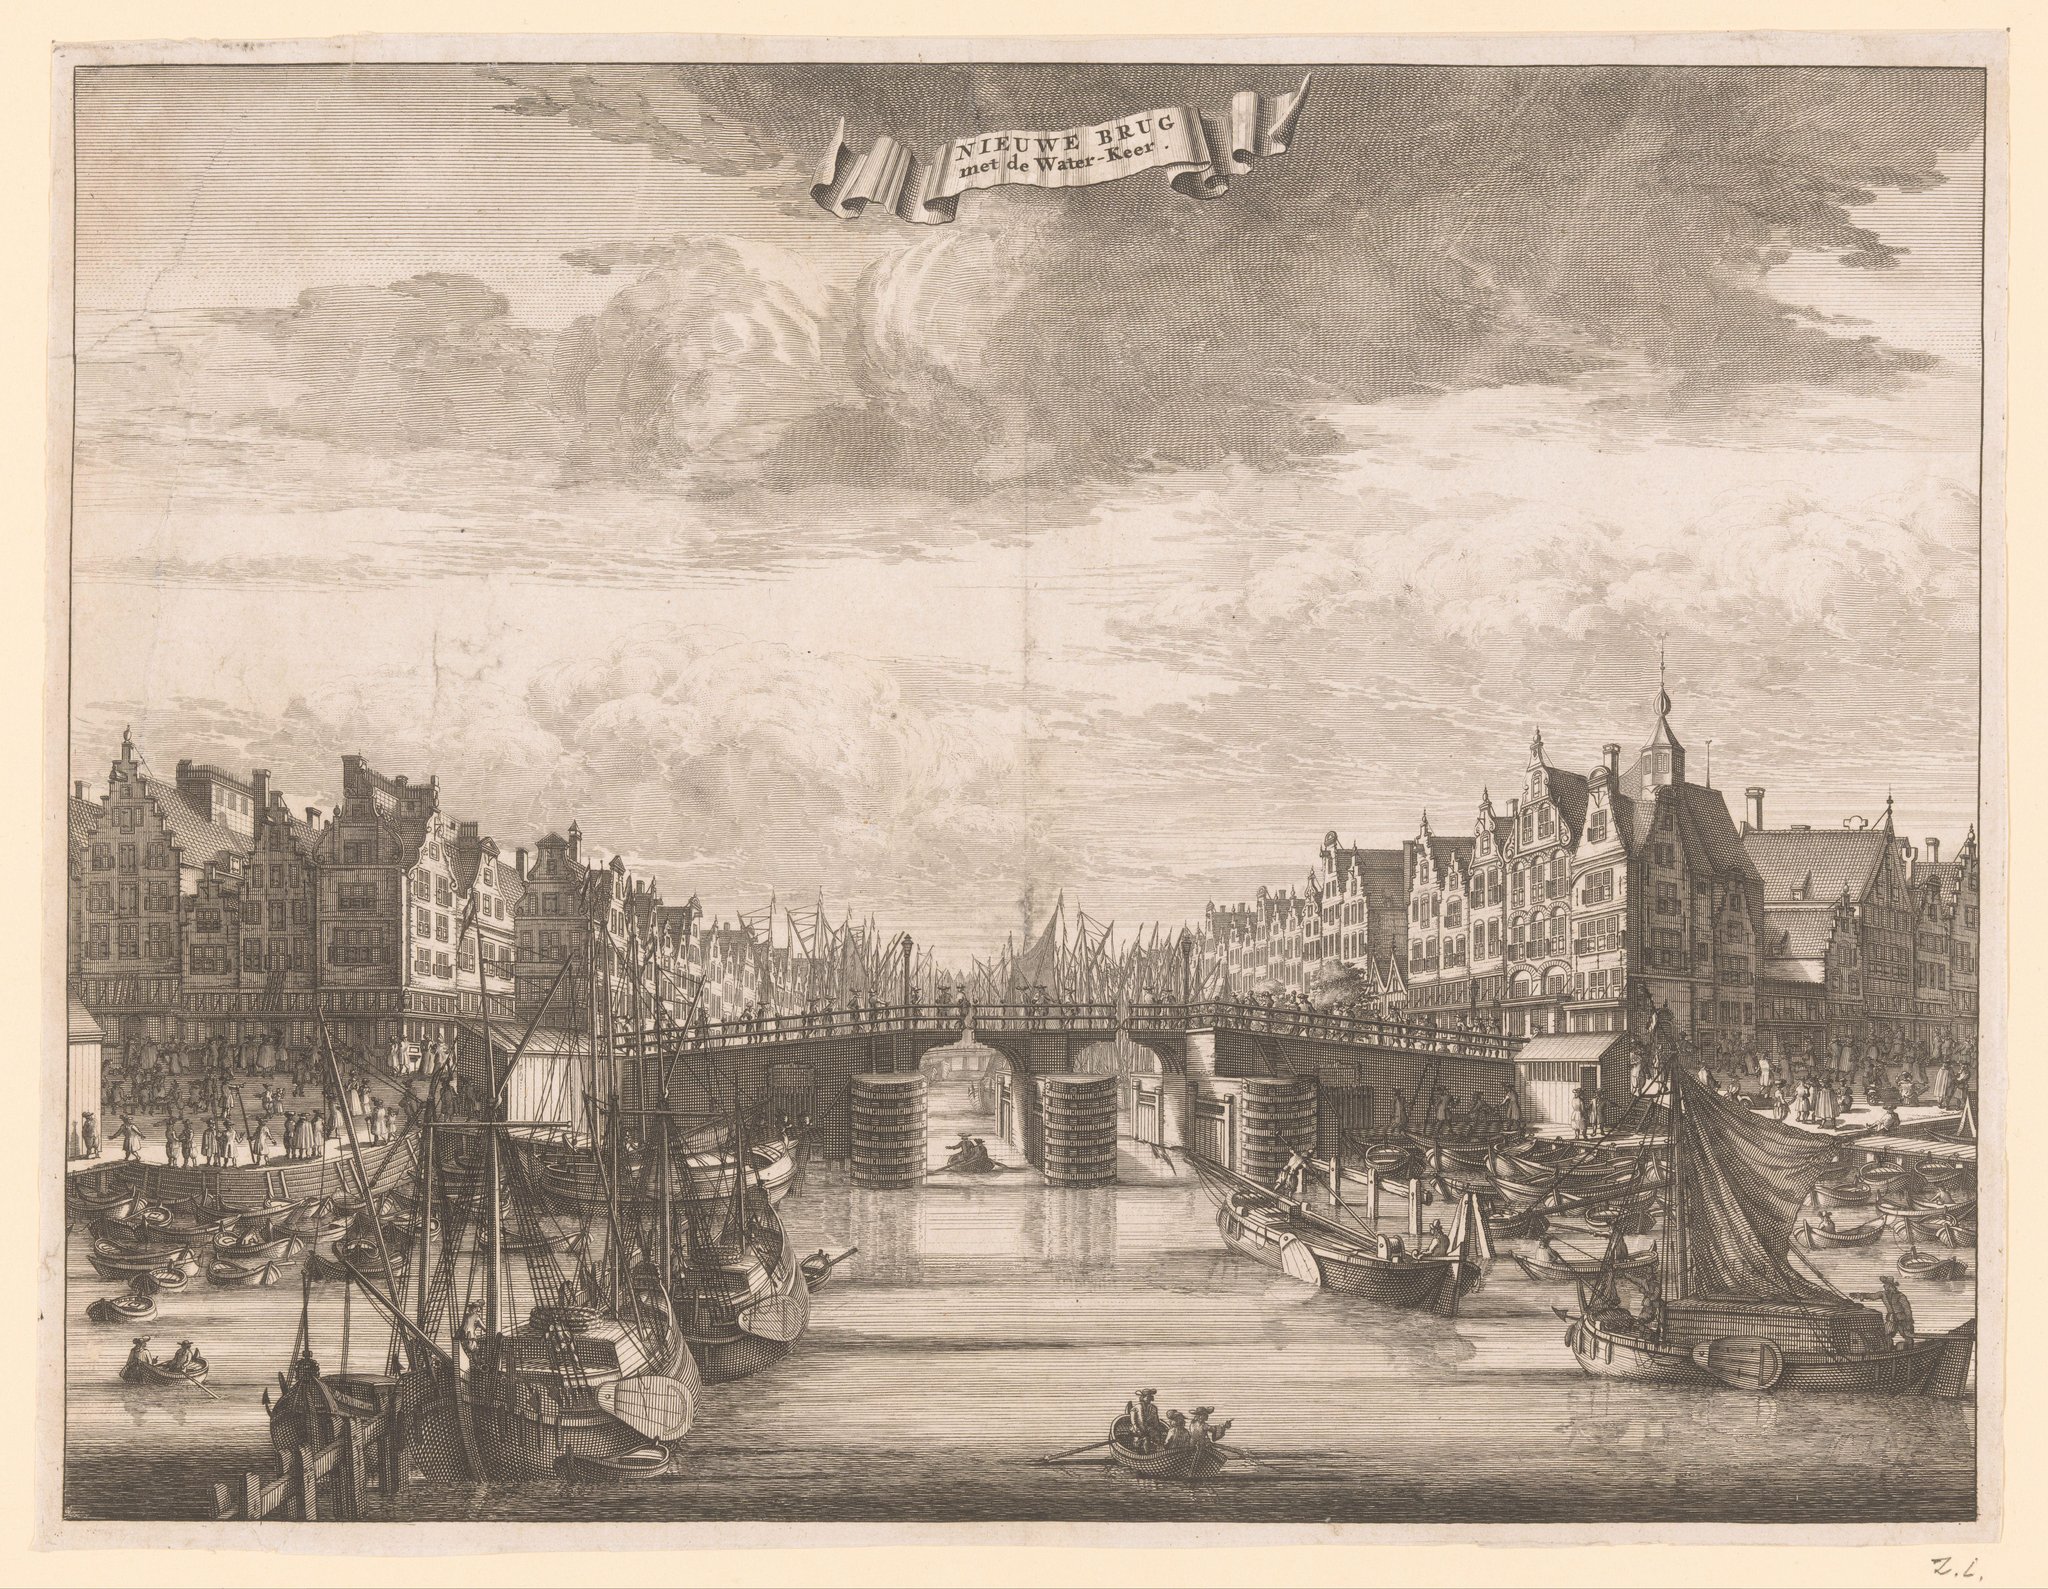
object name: print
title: Gezicht op het Damrak en de Nieuwe Brug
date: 1693-1694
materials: paper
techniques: engraving, etching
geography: amsterdam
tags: sailing-ship, sailing-boat, bridge in city across river, canal, etc., prospect of city, town panorama, silhouette of city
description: Prent uit: Commelin, Caspar. Beschryvinge van Amsterdam (…). 2 dln. Amsterdam: Abraham Wolfgang et al., 1693. Of: Commelin, Caspar. Beschryvinge van Amsterdam (...). 2 dln. Amsterdam: Wed. Aart Dircksz. Oossaan, 1694, dl. 2, tussen pp. 626-627.